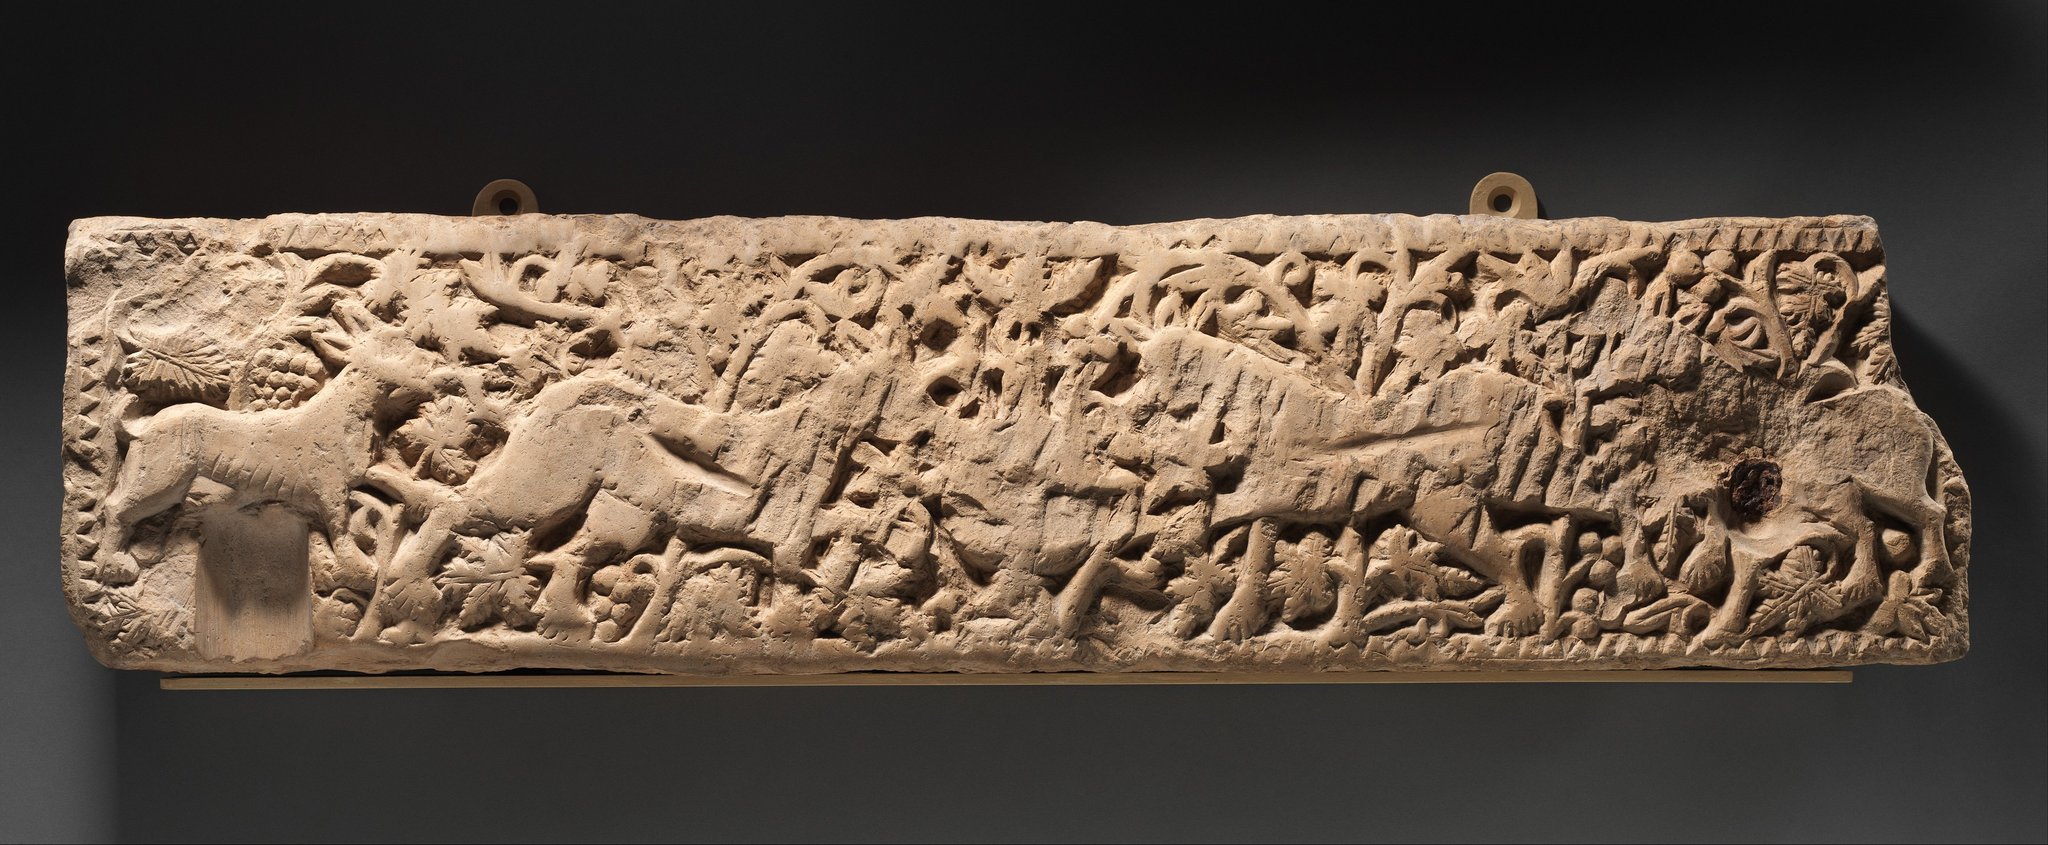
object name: frieze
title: Panel with Animals Flanking a Vase Against a Pattern of Scrolls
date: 501-700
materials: limestone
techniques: carving, relief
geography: egypt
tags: animals